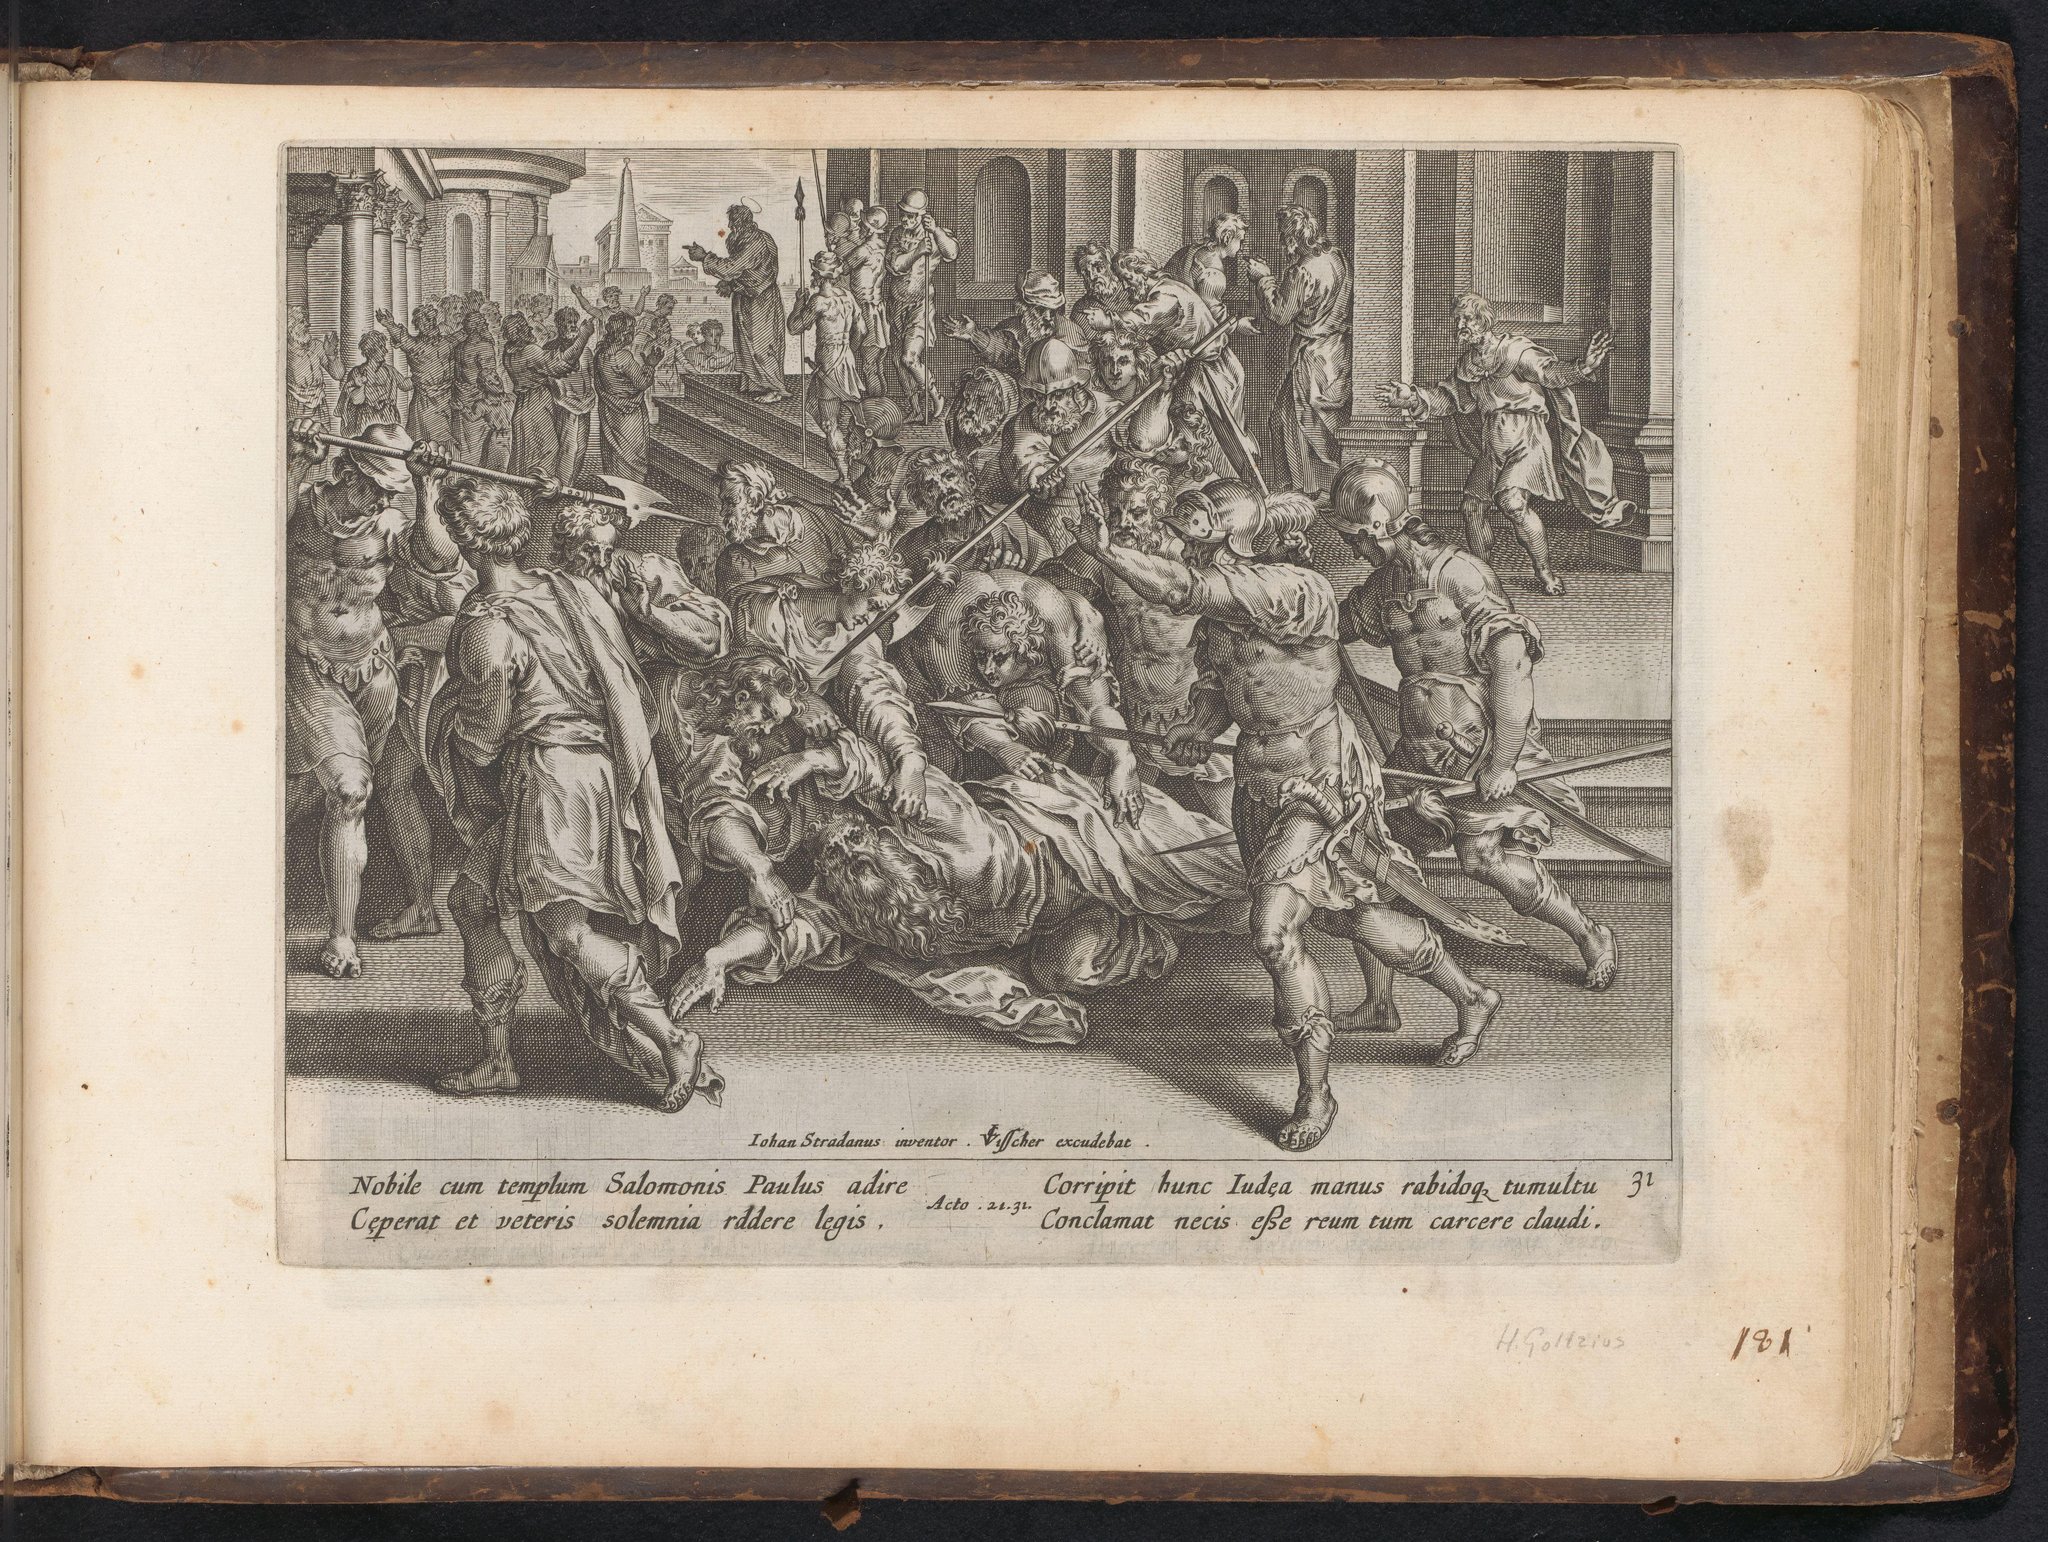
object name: print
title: Acta Apostolorum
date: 1643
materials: paper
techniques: engraving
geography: amsterdam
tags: paul speaks to the people from the stairs, paul is dragged out of the temple by the jews; he is rescued by soldiers, who arrest him and carry him away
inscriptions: number: ‘181’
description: Wanneer de apostel Paulus in Jeruzalem de tempel wil betreden, wordt hij door de Joden tegen de grond gewerkt en geslagen. Romeinse soldaten verwijderen de oproerkraaiers en arresteren Paulus. Op de achtergrond spreekt Paulus de Joodse menigte toe, vlak na zijn arrestatie. Onder de voorstelling een verwijzing in het Latijn naar de Bijbeltekst in Hand. 21:31. Deze prent maakt deel uit van een album.